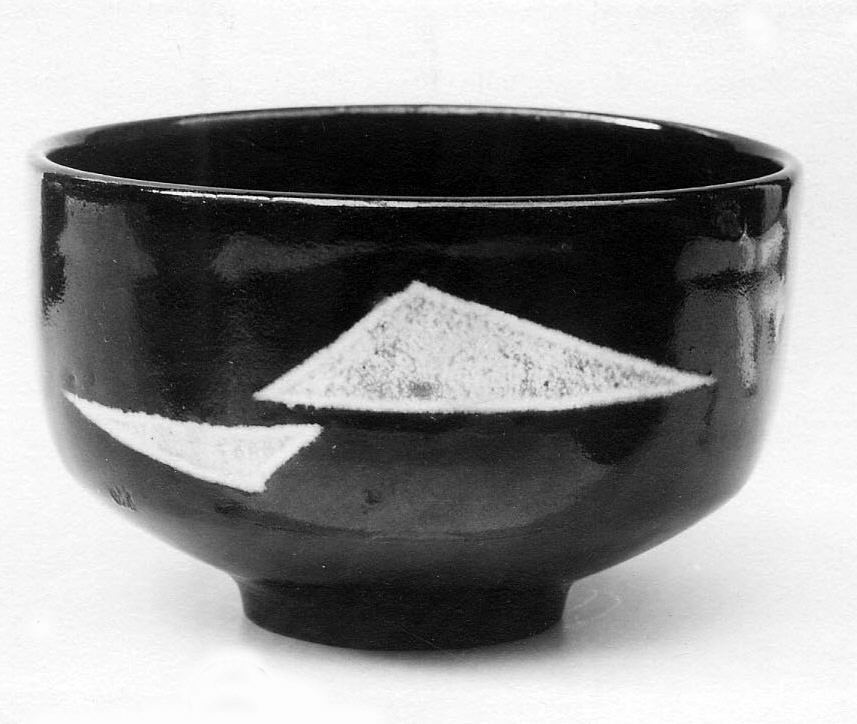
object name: teabowl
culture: japanese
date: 1680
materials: clay, glaze